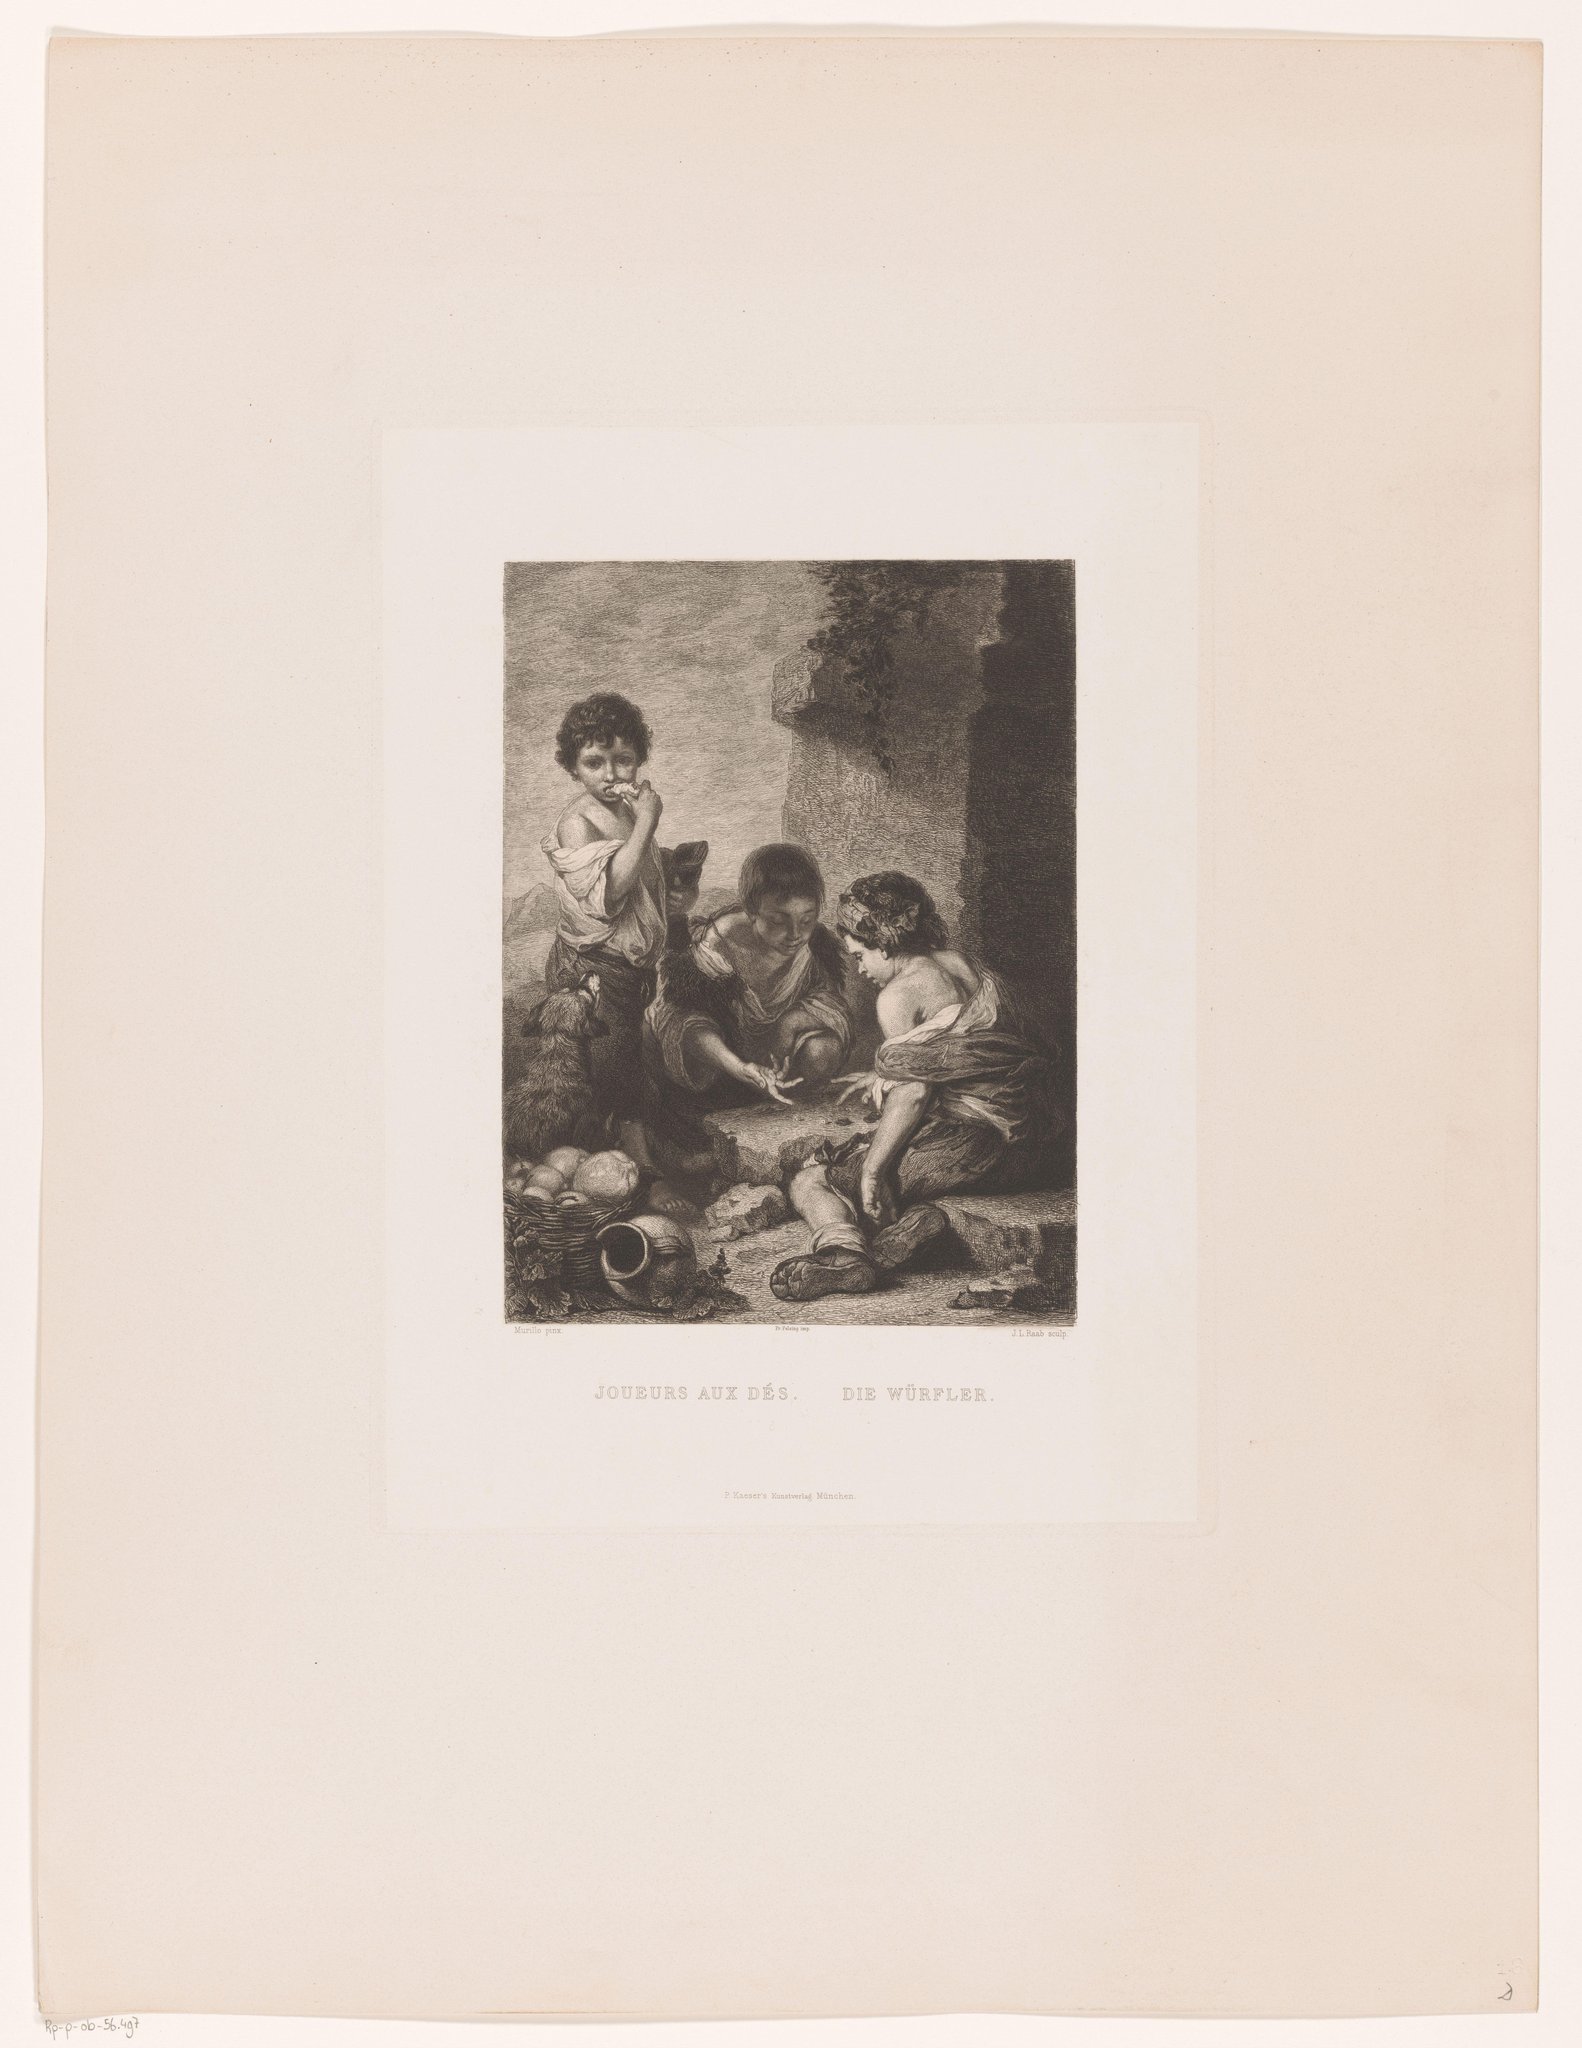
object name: print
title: Dobbelende kinderen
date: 1835-1899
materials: paper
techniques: etching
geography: munich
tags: child, dice-games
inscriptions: collector's mark: Lugt 2228, number: ‘18’